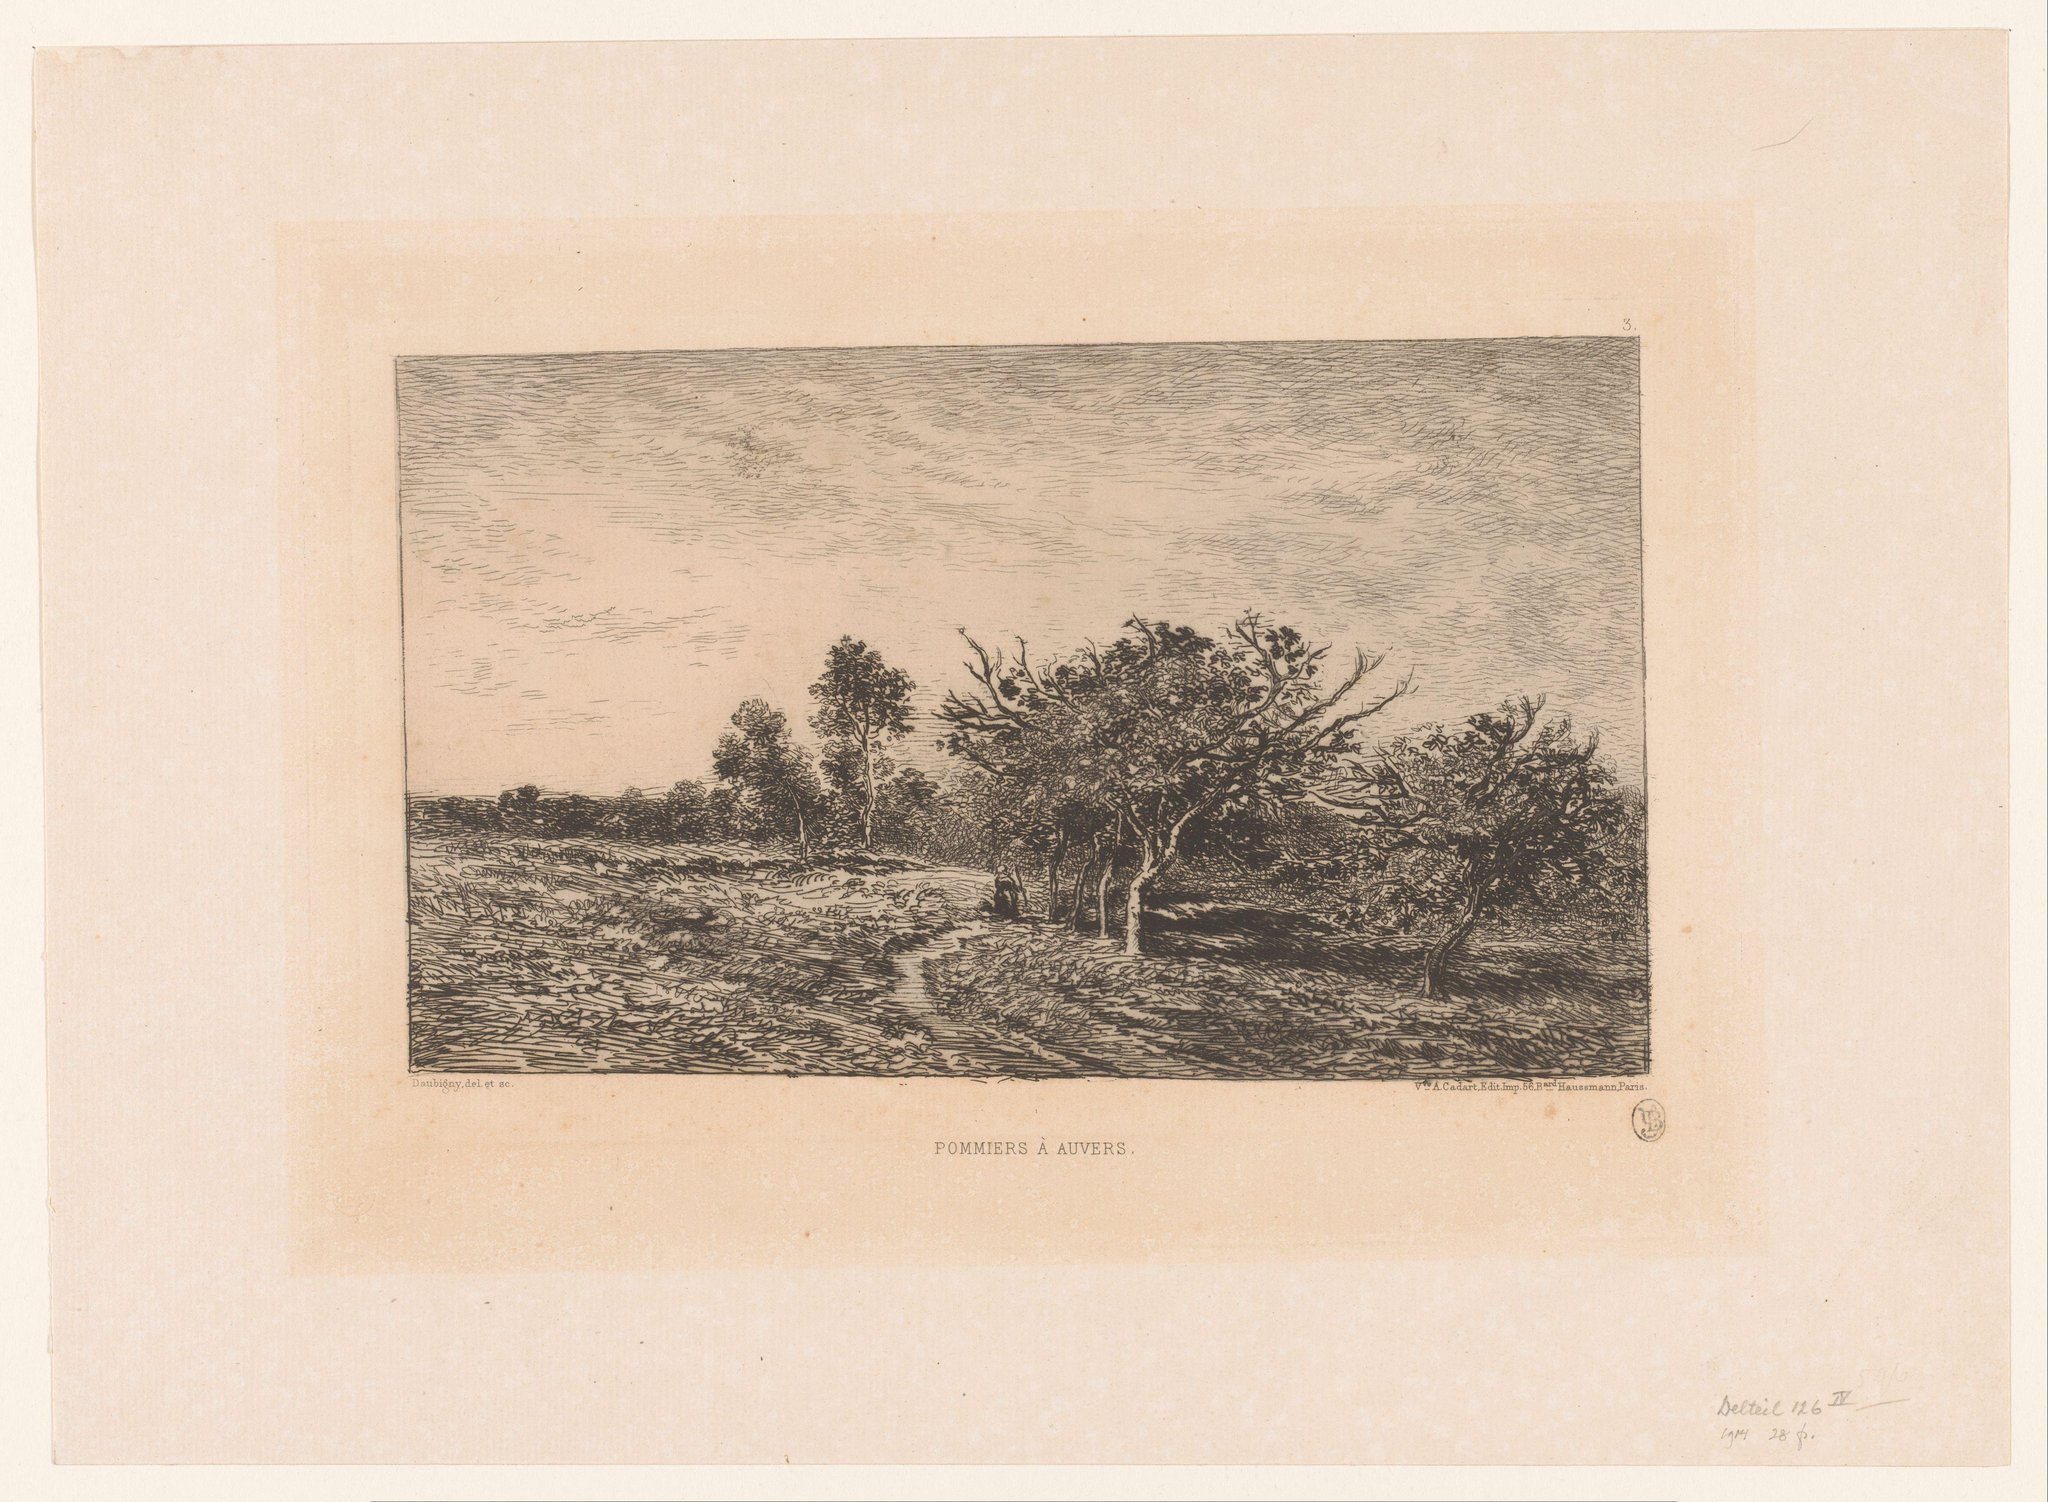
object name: print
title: Pommiers à Auvers.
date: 1877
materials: paper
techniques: drypoint, engraving, etching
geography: paris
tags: landscapes, trees: apple-tree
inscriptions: watermark, collector's mark: Lugt 2228, check stamp: ‘onleesbaar’, collector's mark: Lugt 421